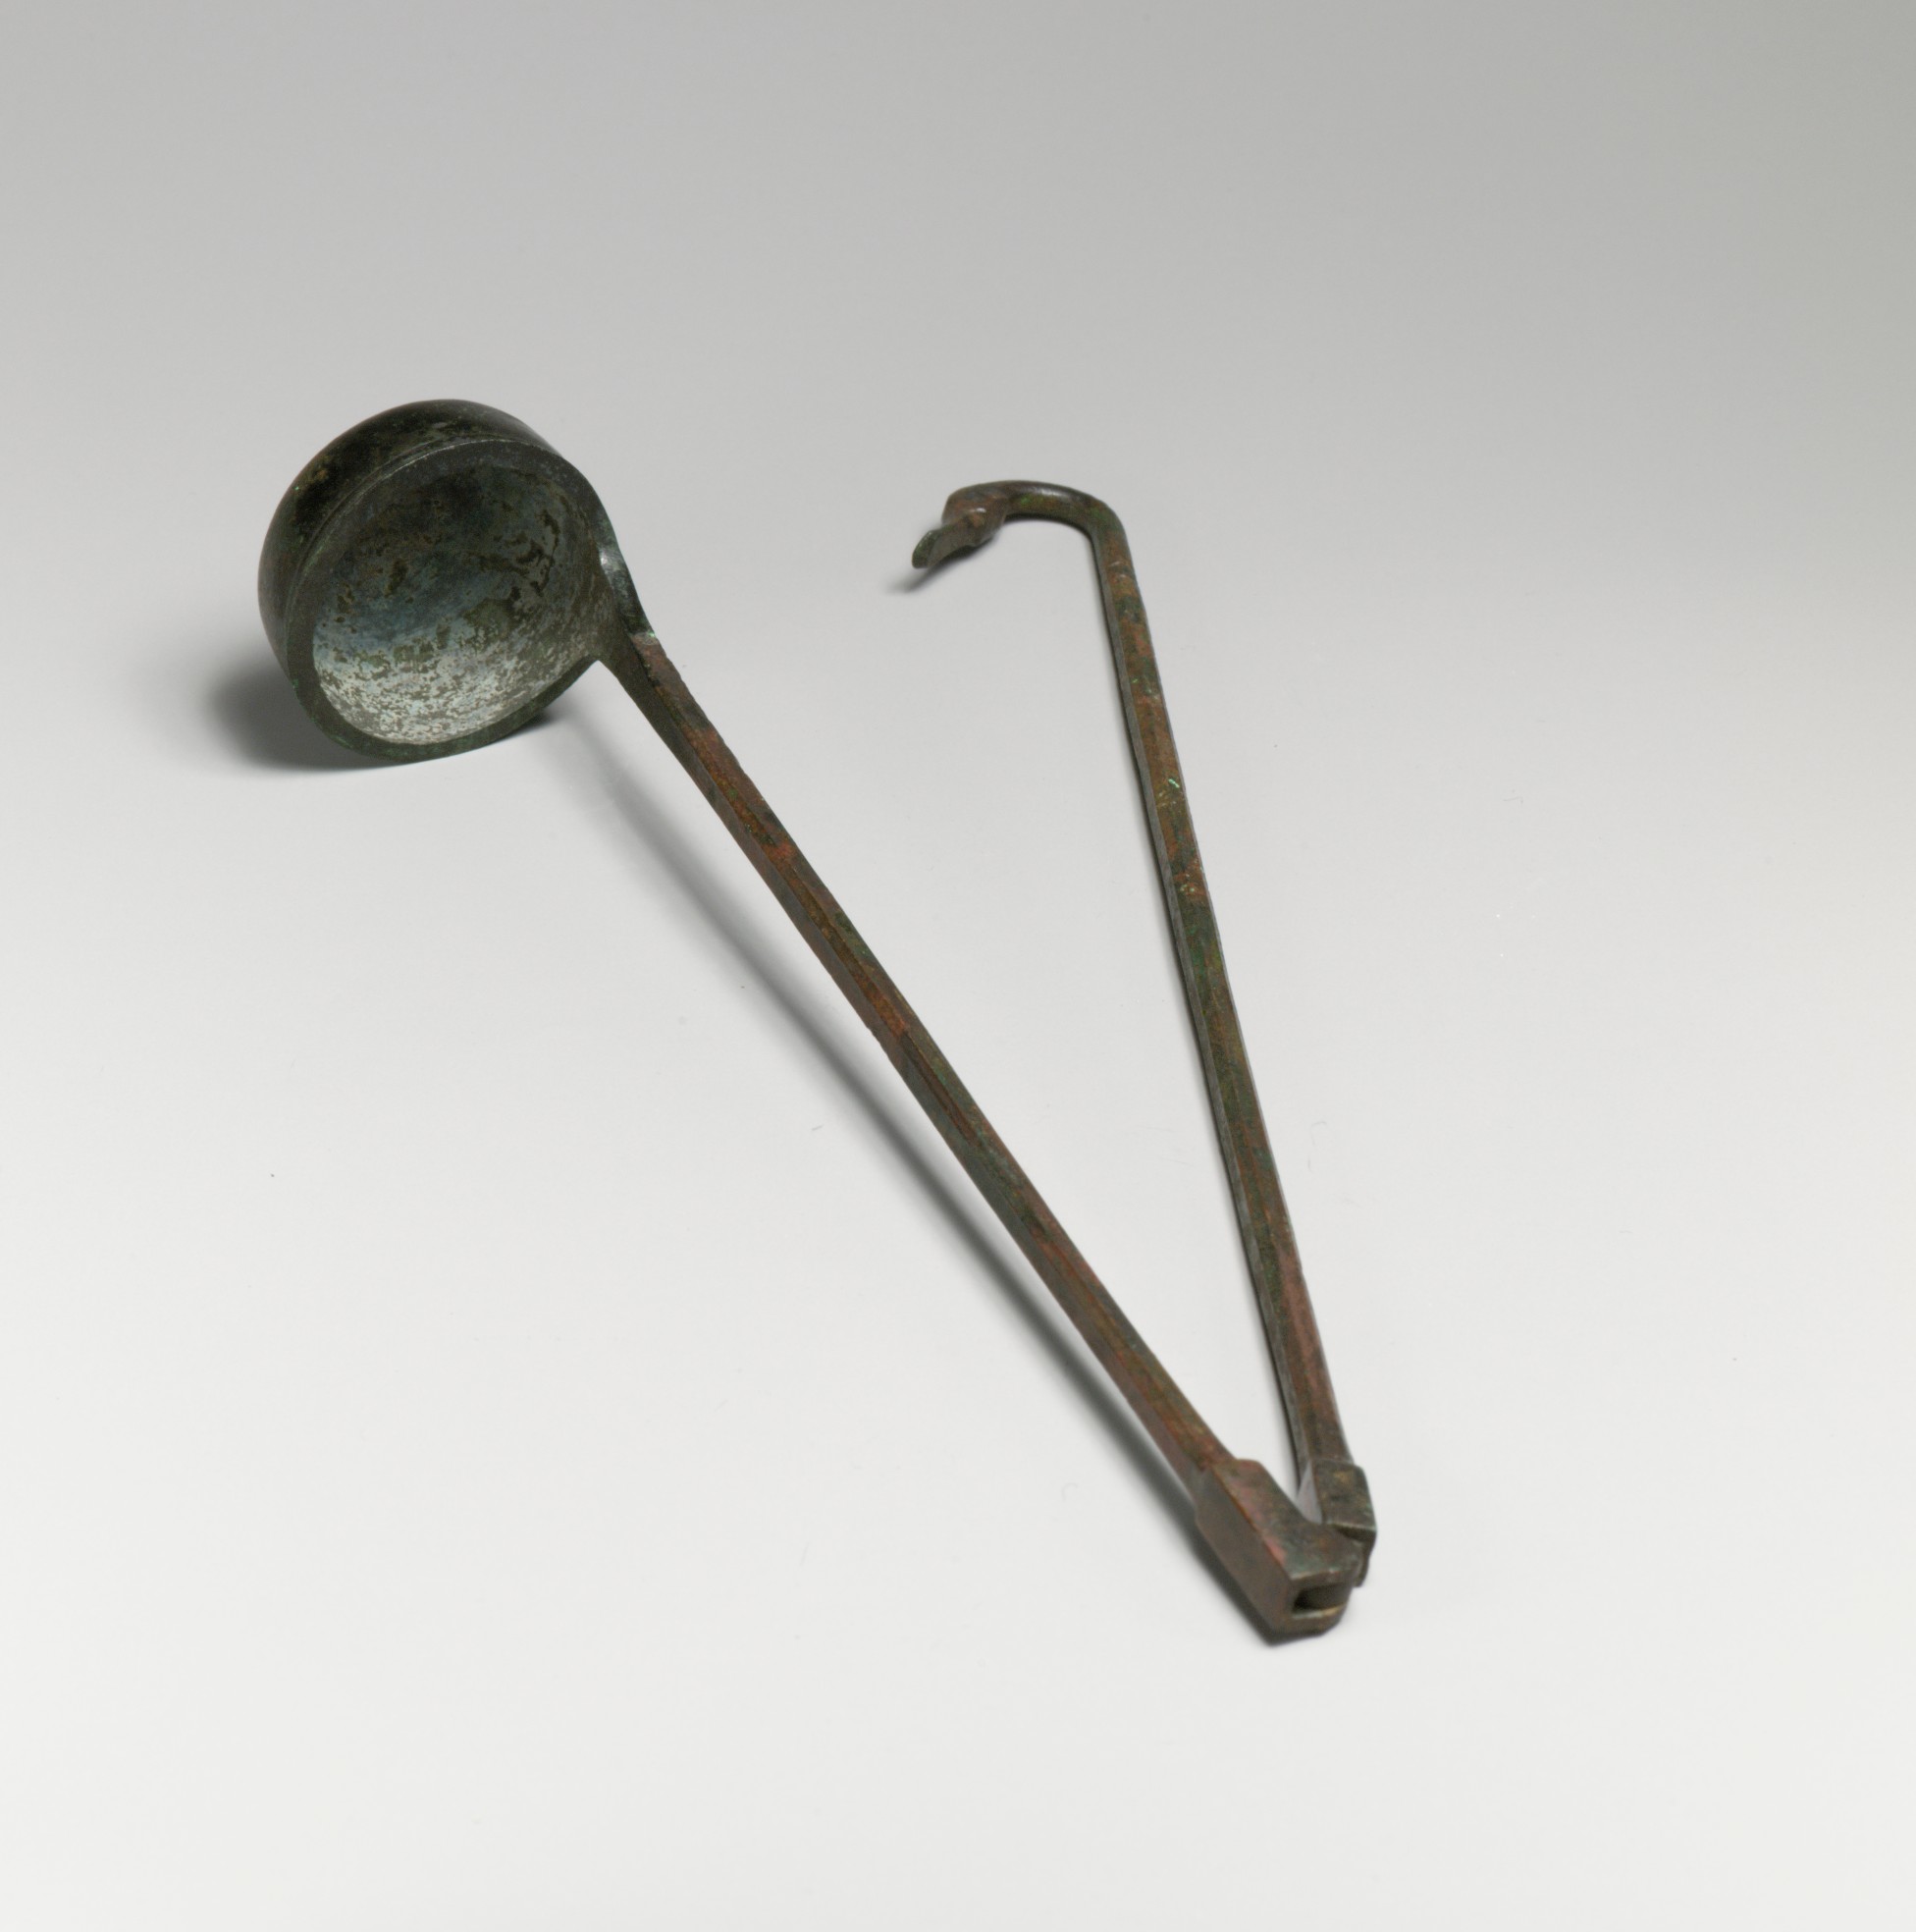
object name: kyathos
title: Bronze simpulum (ladle)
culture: roman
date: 101-200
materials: bronze